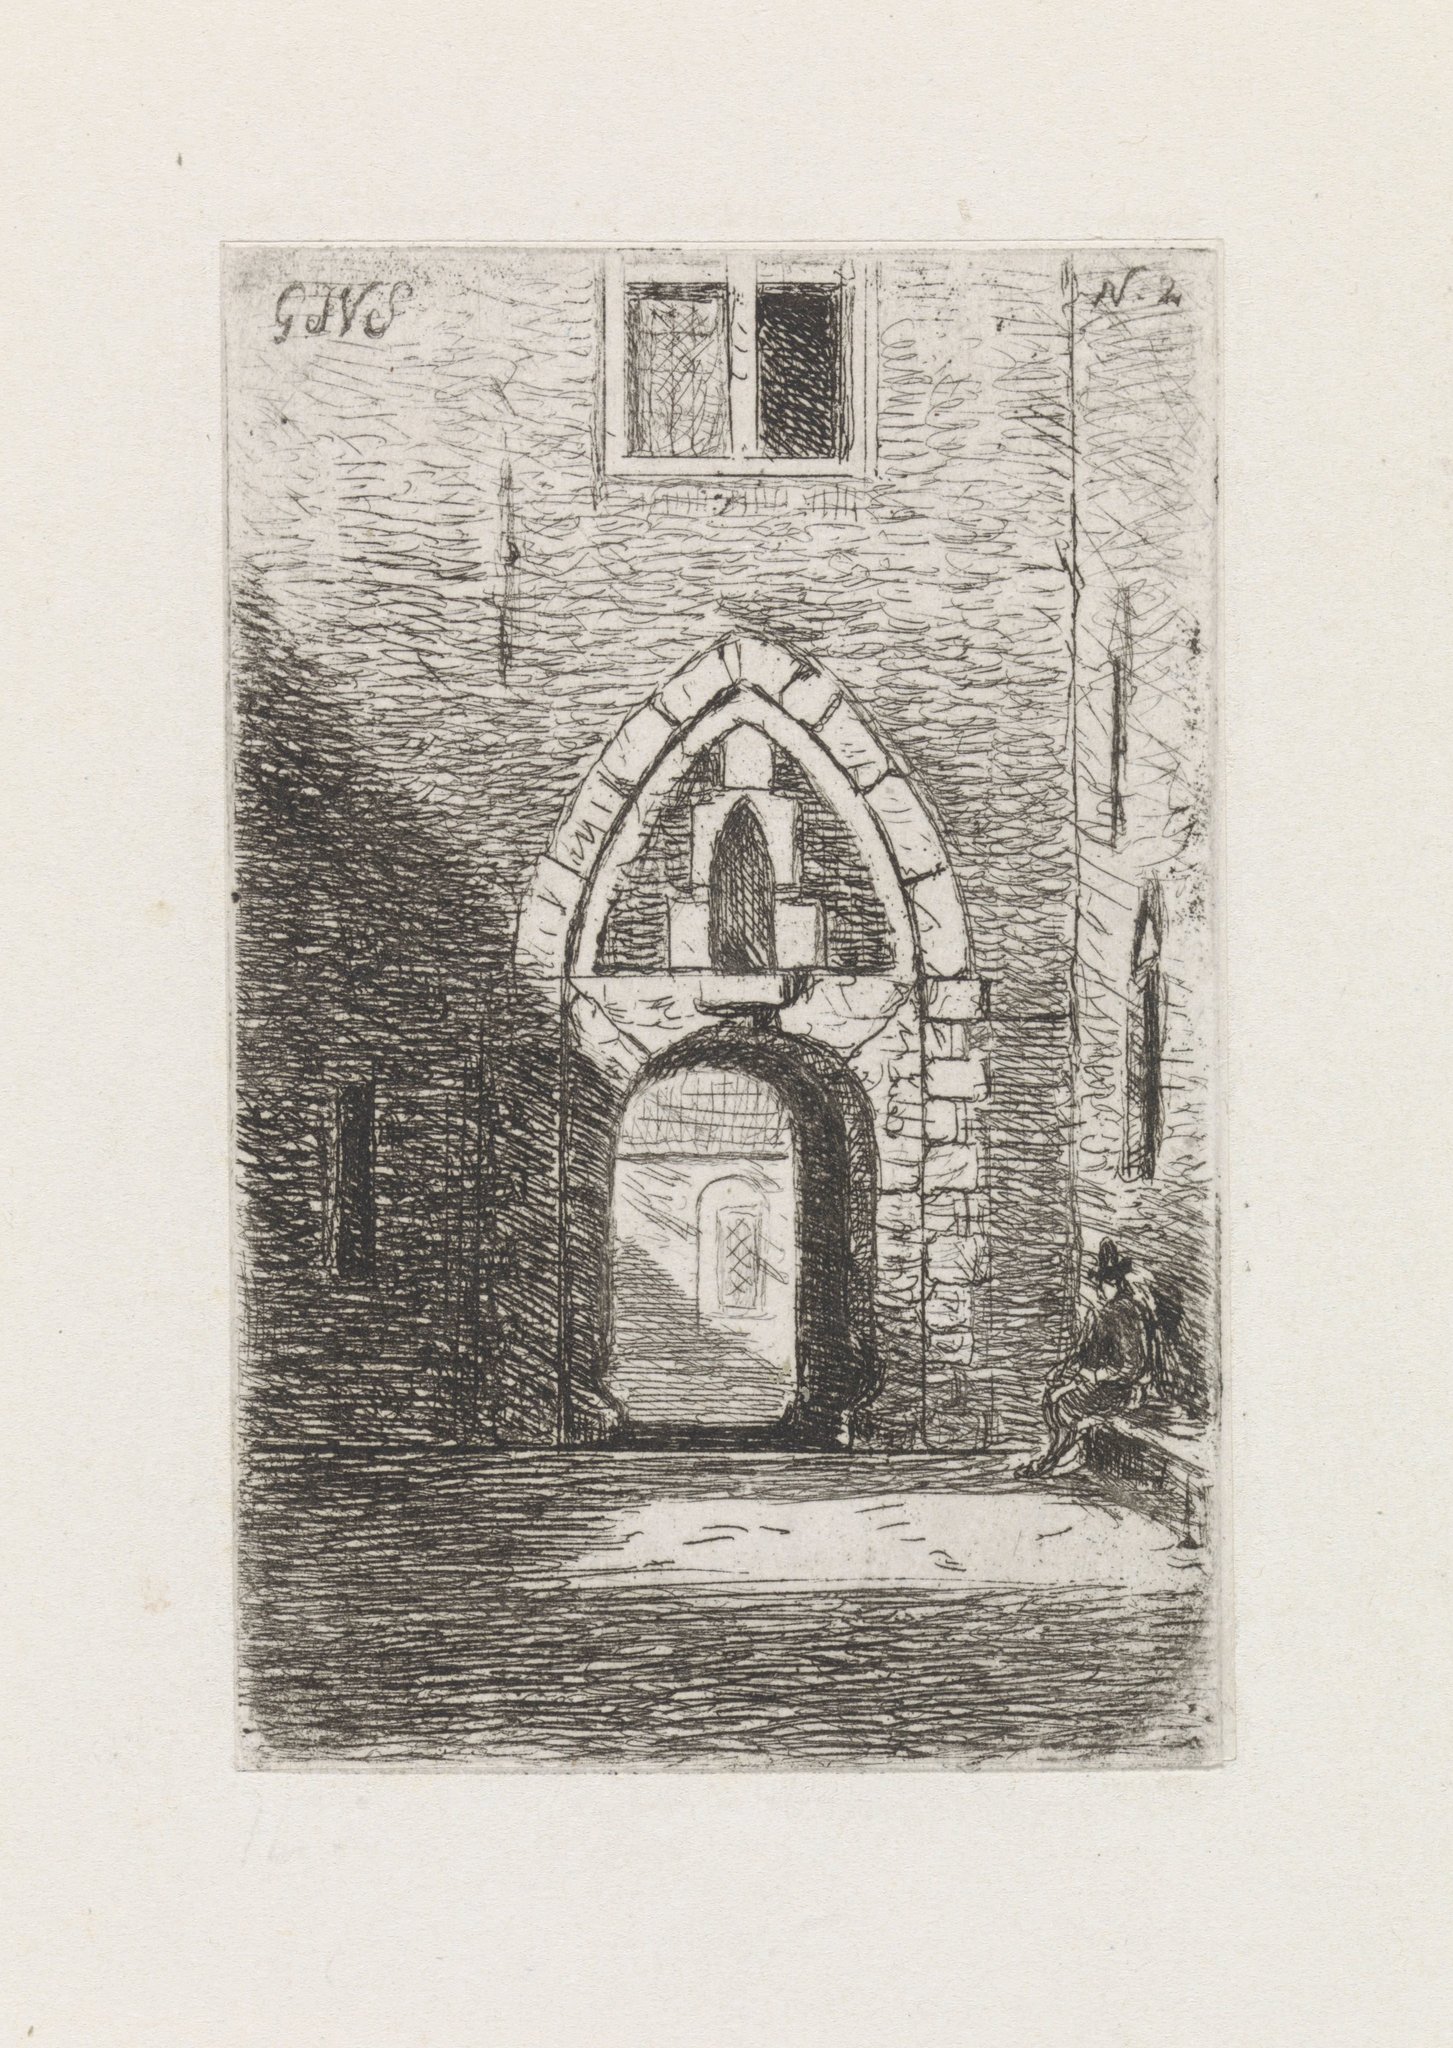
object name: print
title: Gezicht op een poort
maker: gijsbertus johannes verspuy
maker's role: print maker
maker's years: 1823-1862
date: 1833-1862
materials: paper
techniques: etching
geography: netherlands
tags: gate, entrance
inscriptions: collector's mark: Lugt 2228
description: Gezicht op een poort. Links een zittende figuur op een bank. Rechtsboven N.2.